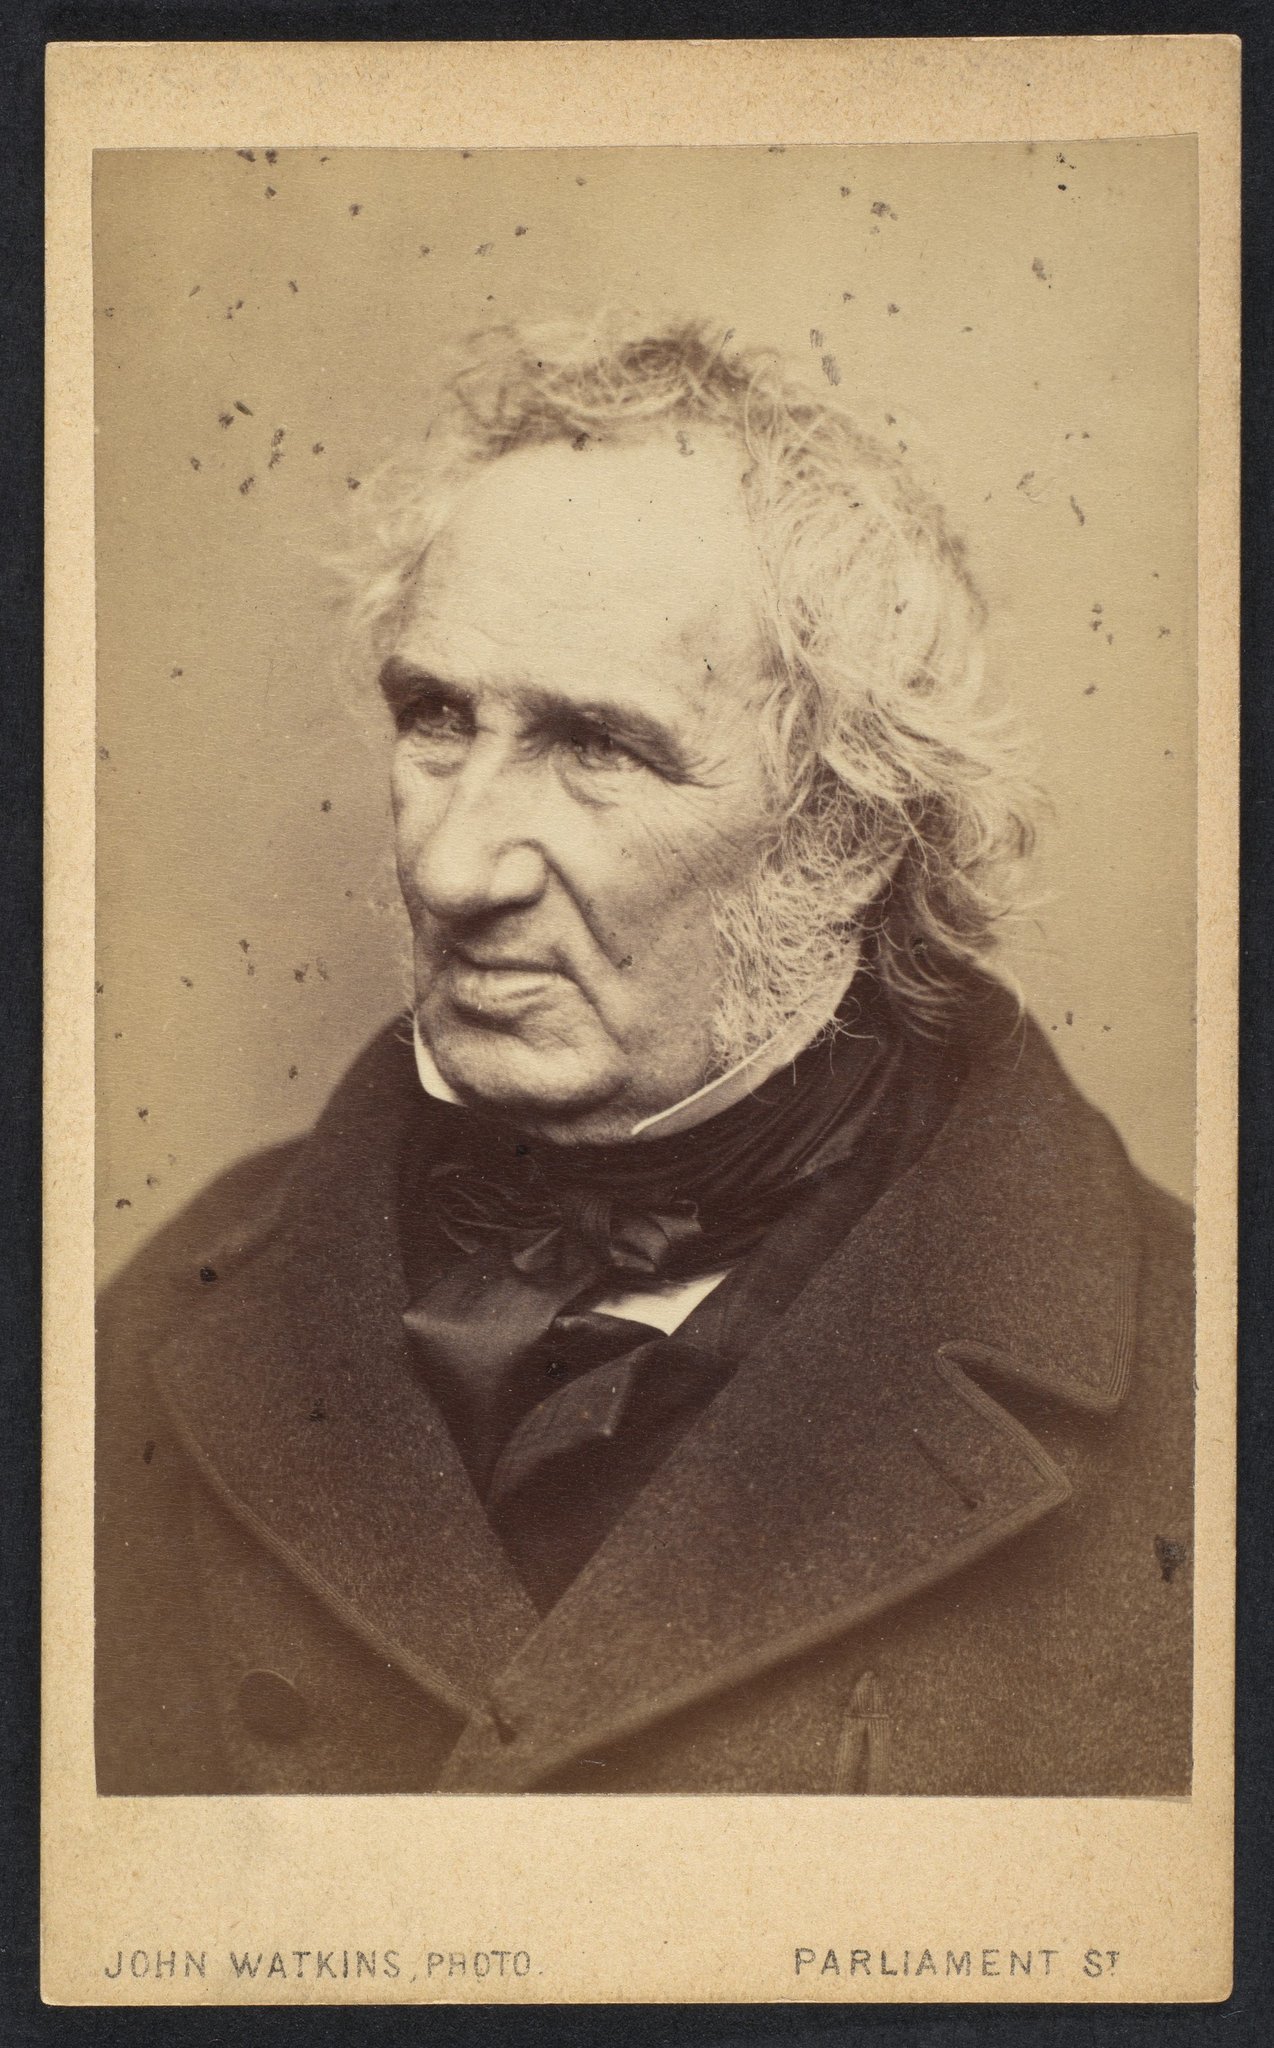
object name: carte de visite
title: [John Burnet]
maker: john and charles watkins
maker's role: photography studio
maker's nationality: british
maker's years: 1840-1875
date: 1860-1869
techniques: albumen silver print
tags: men,portraits